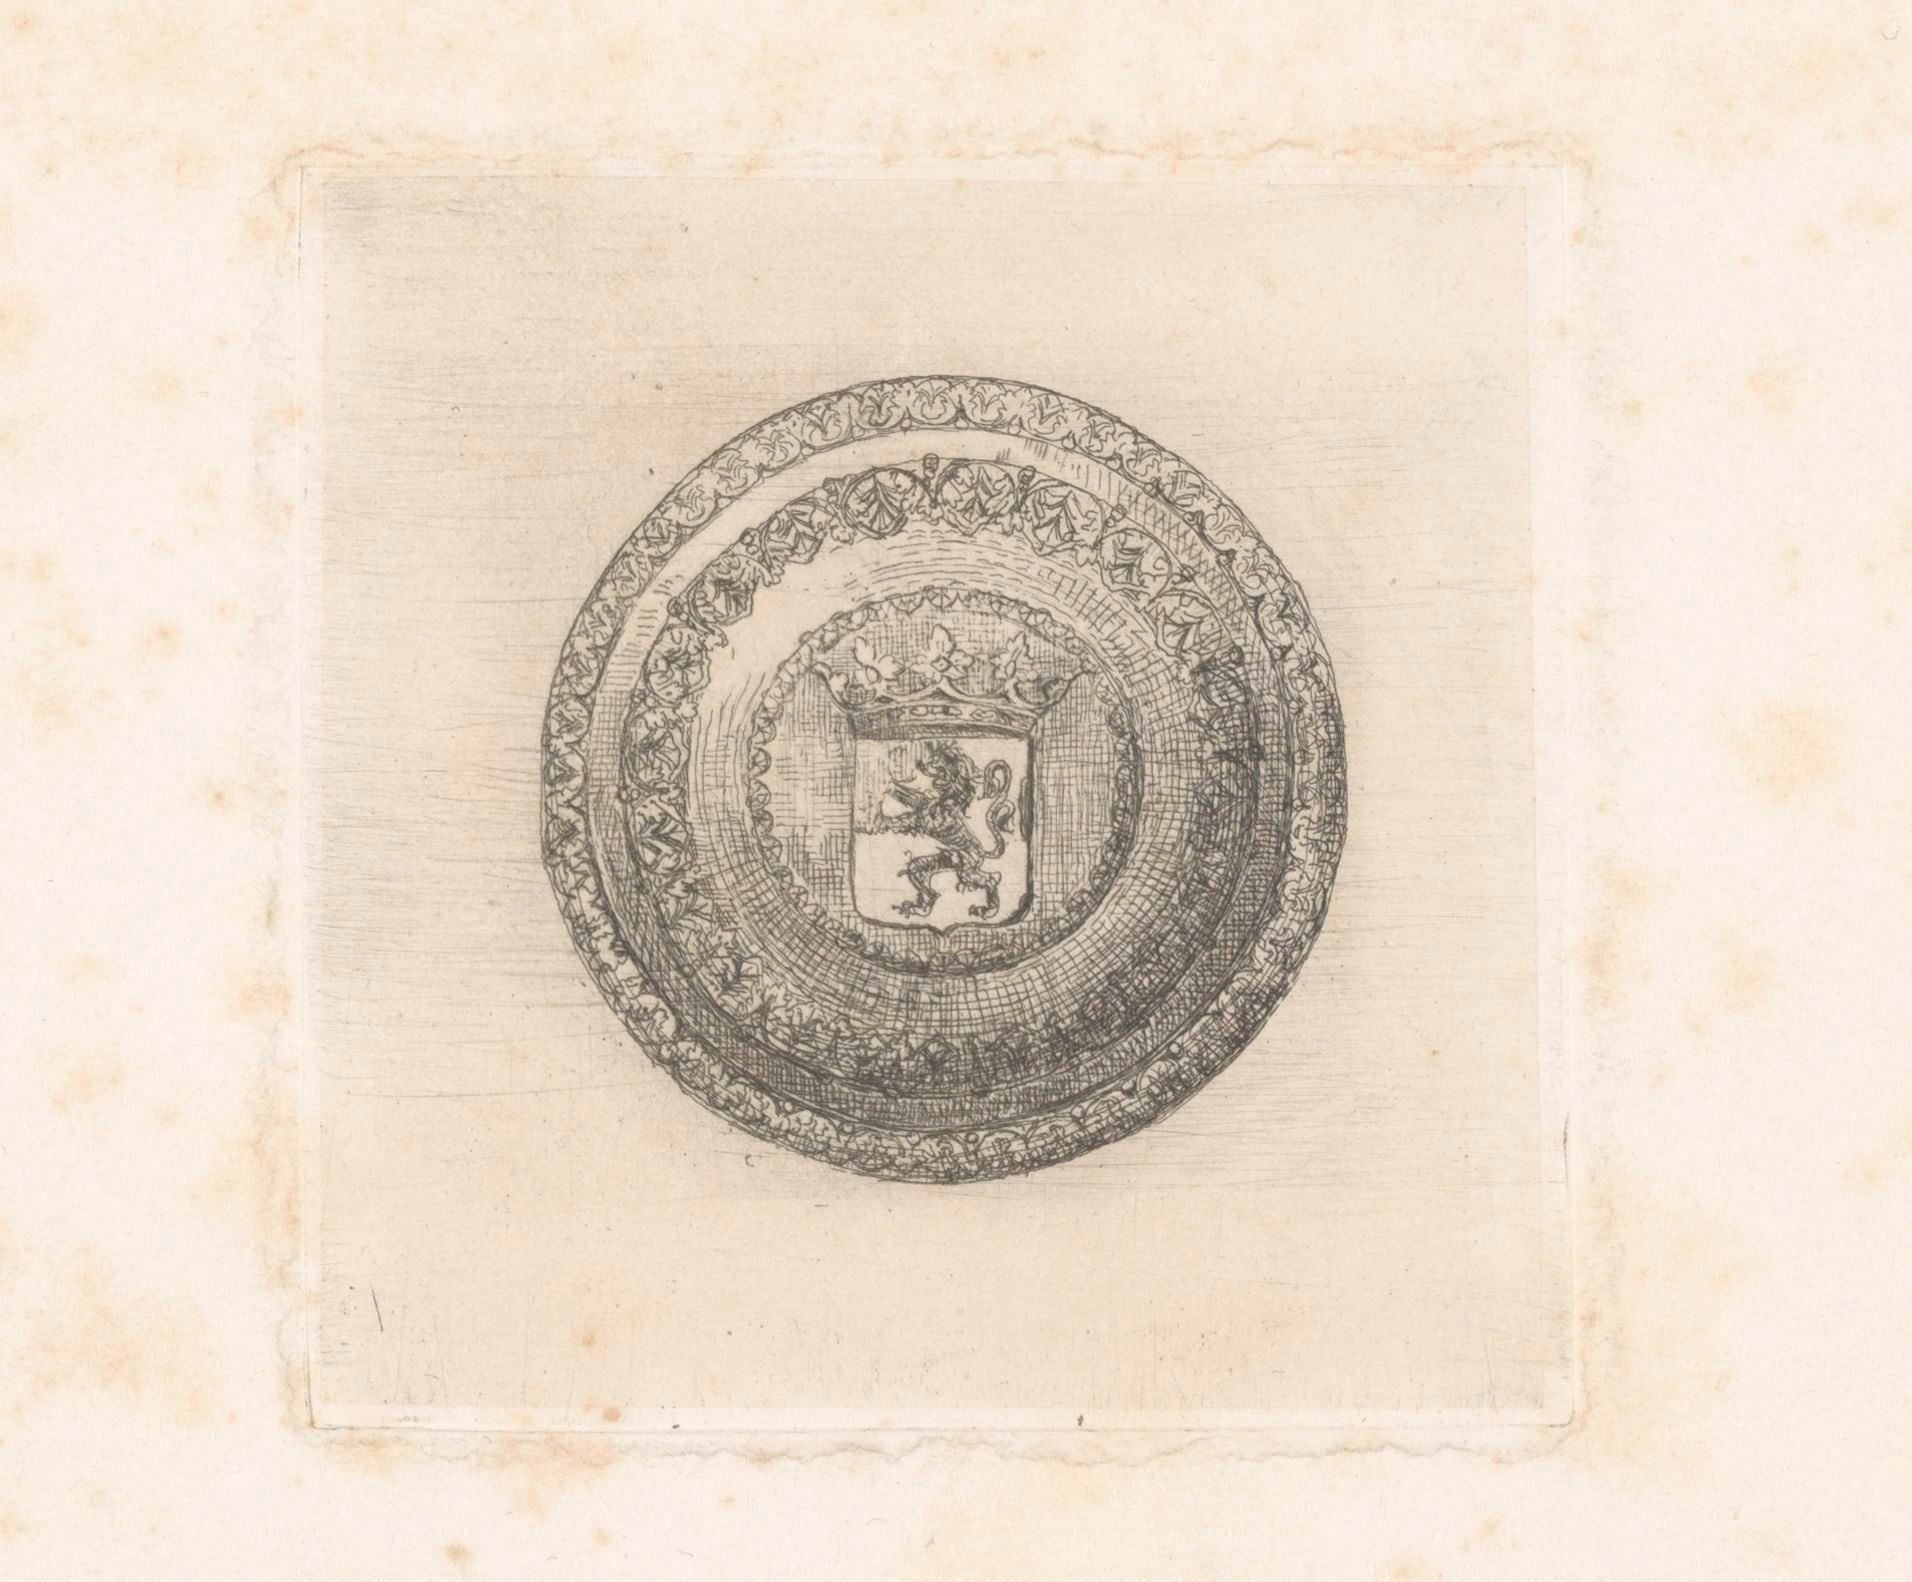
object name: ornament print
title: Ornament met leeuw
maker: Anonymous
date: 1600-1800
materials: paper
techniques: etching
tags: ornaments ~ art, beasts of prey, predatory animals: lion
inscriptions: collector's mark: Lugt 2233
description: Een rond ornament mogelijk een bord, met in het midden een gekroond wapenschild met een leeuw.